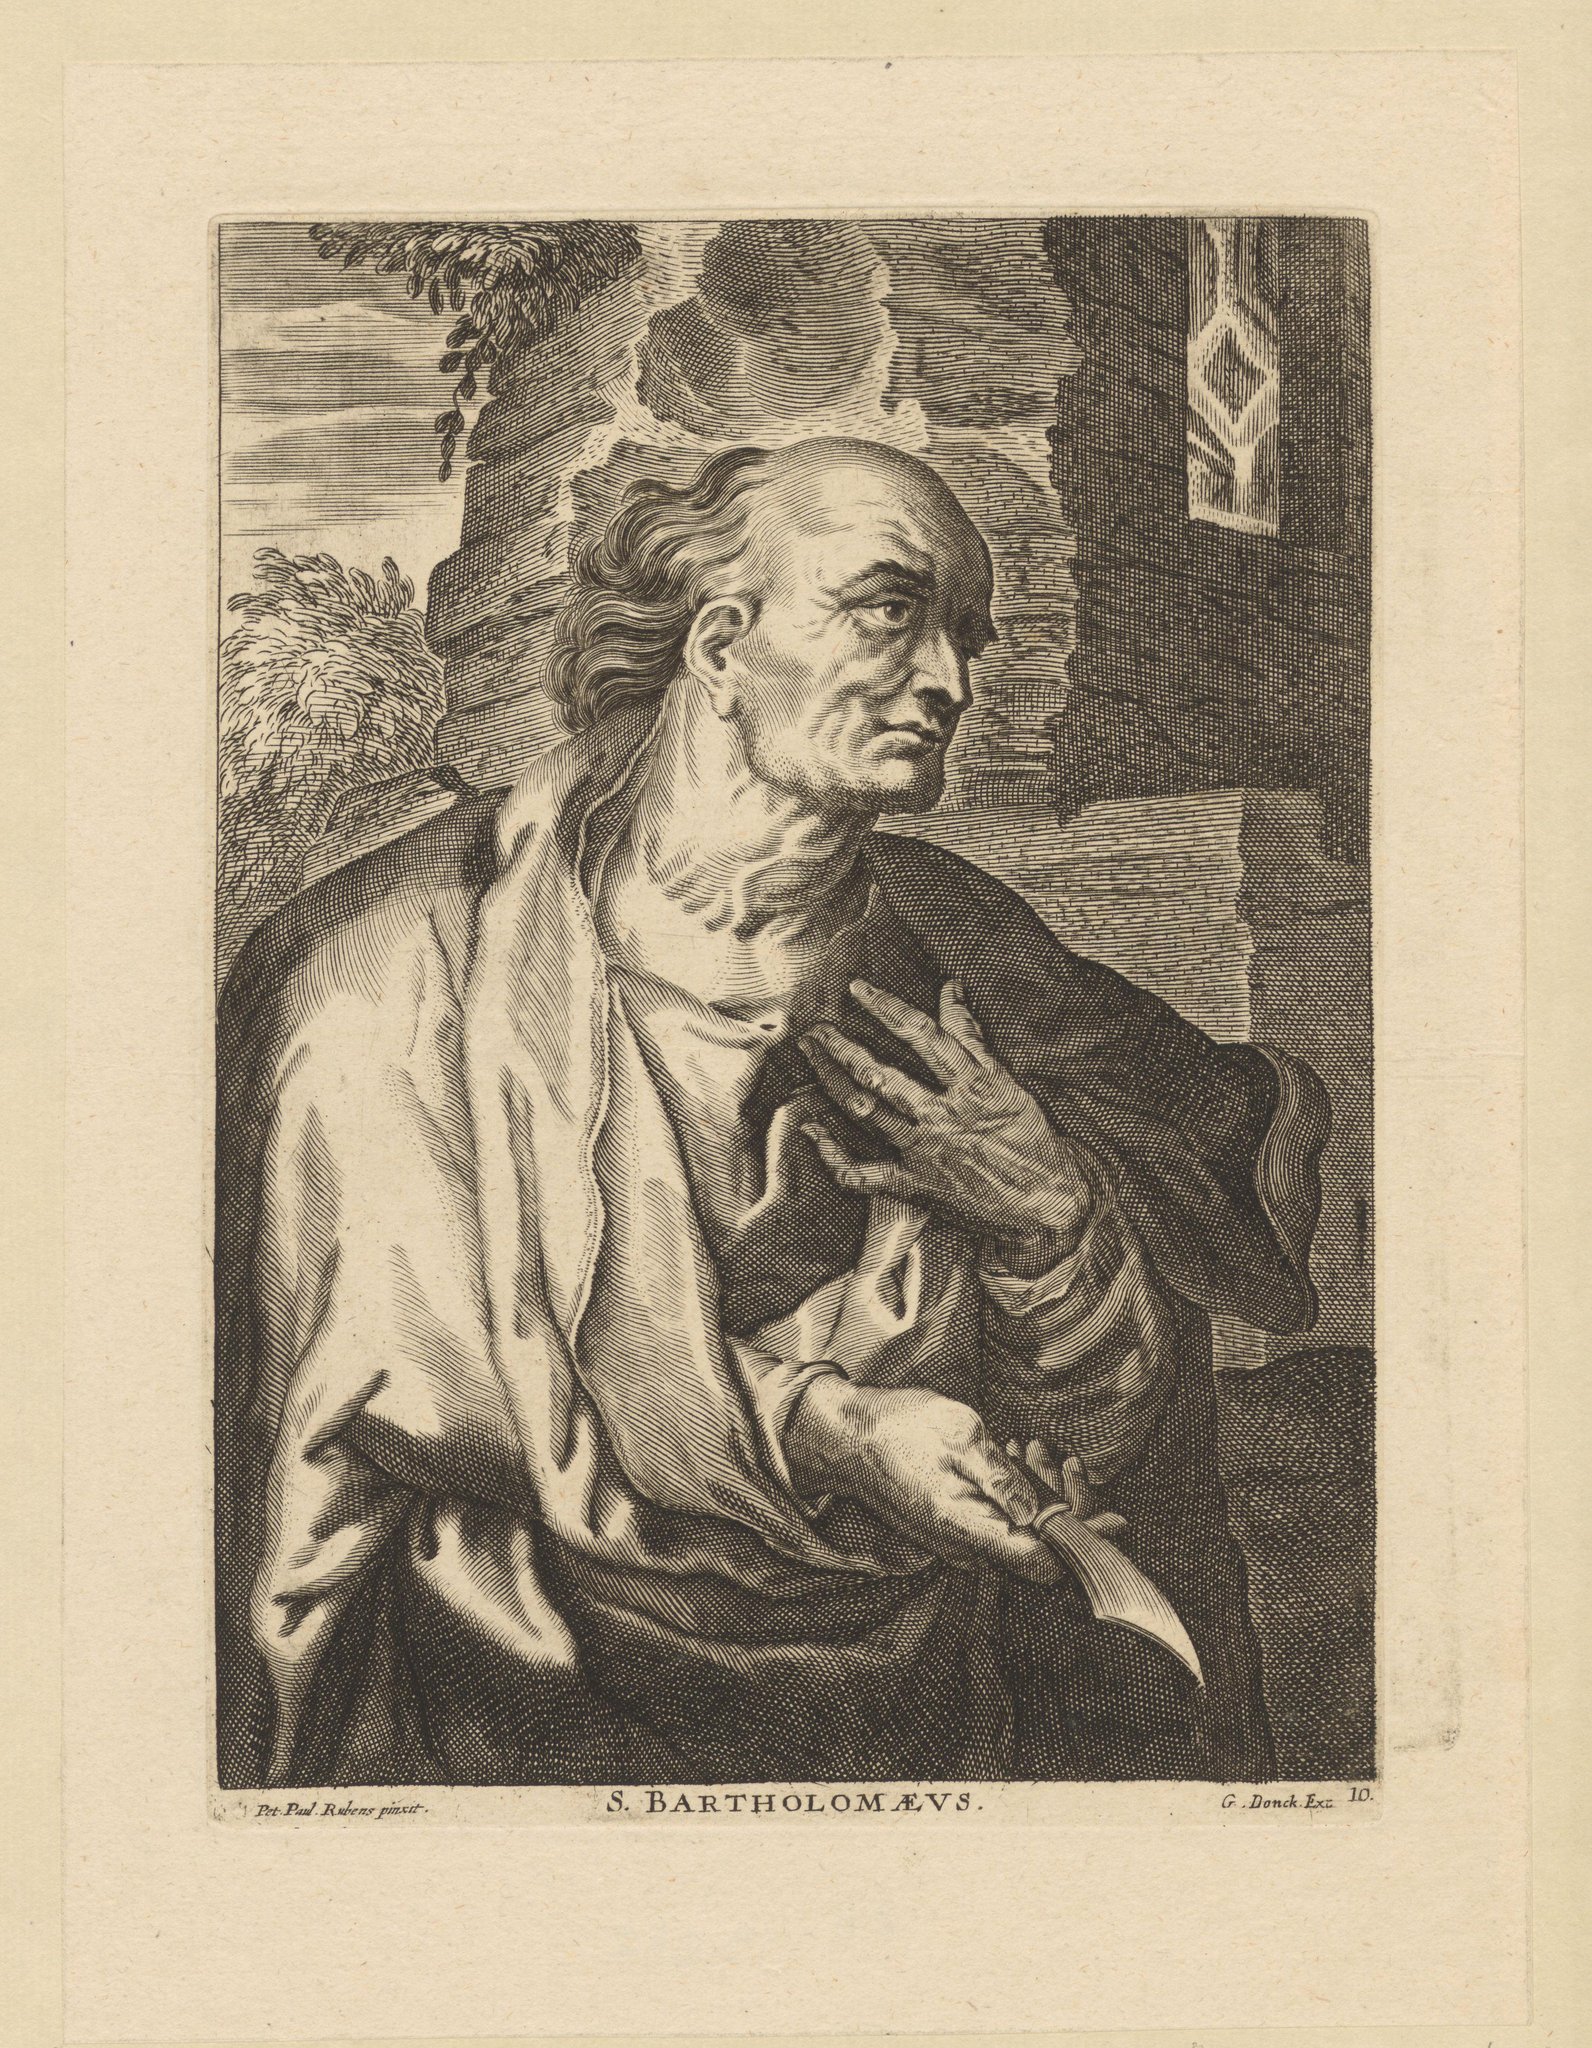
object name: print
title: H. Bartholomeus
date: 1611-1612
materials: paper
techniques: engraving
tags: the apostle bartholomew; possible attributes: book, devil or dragon at feet, knife, scroll, flayed skin, staff